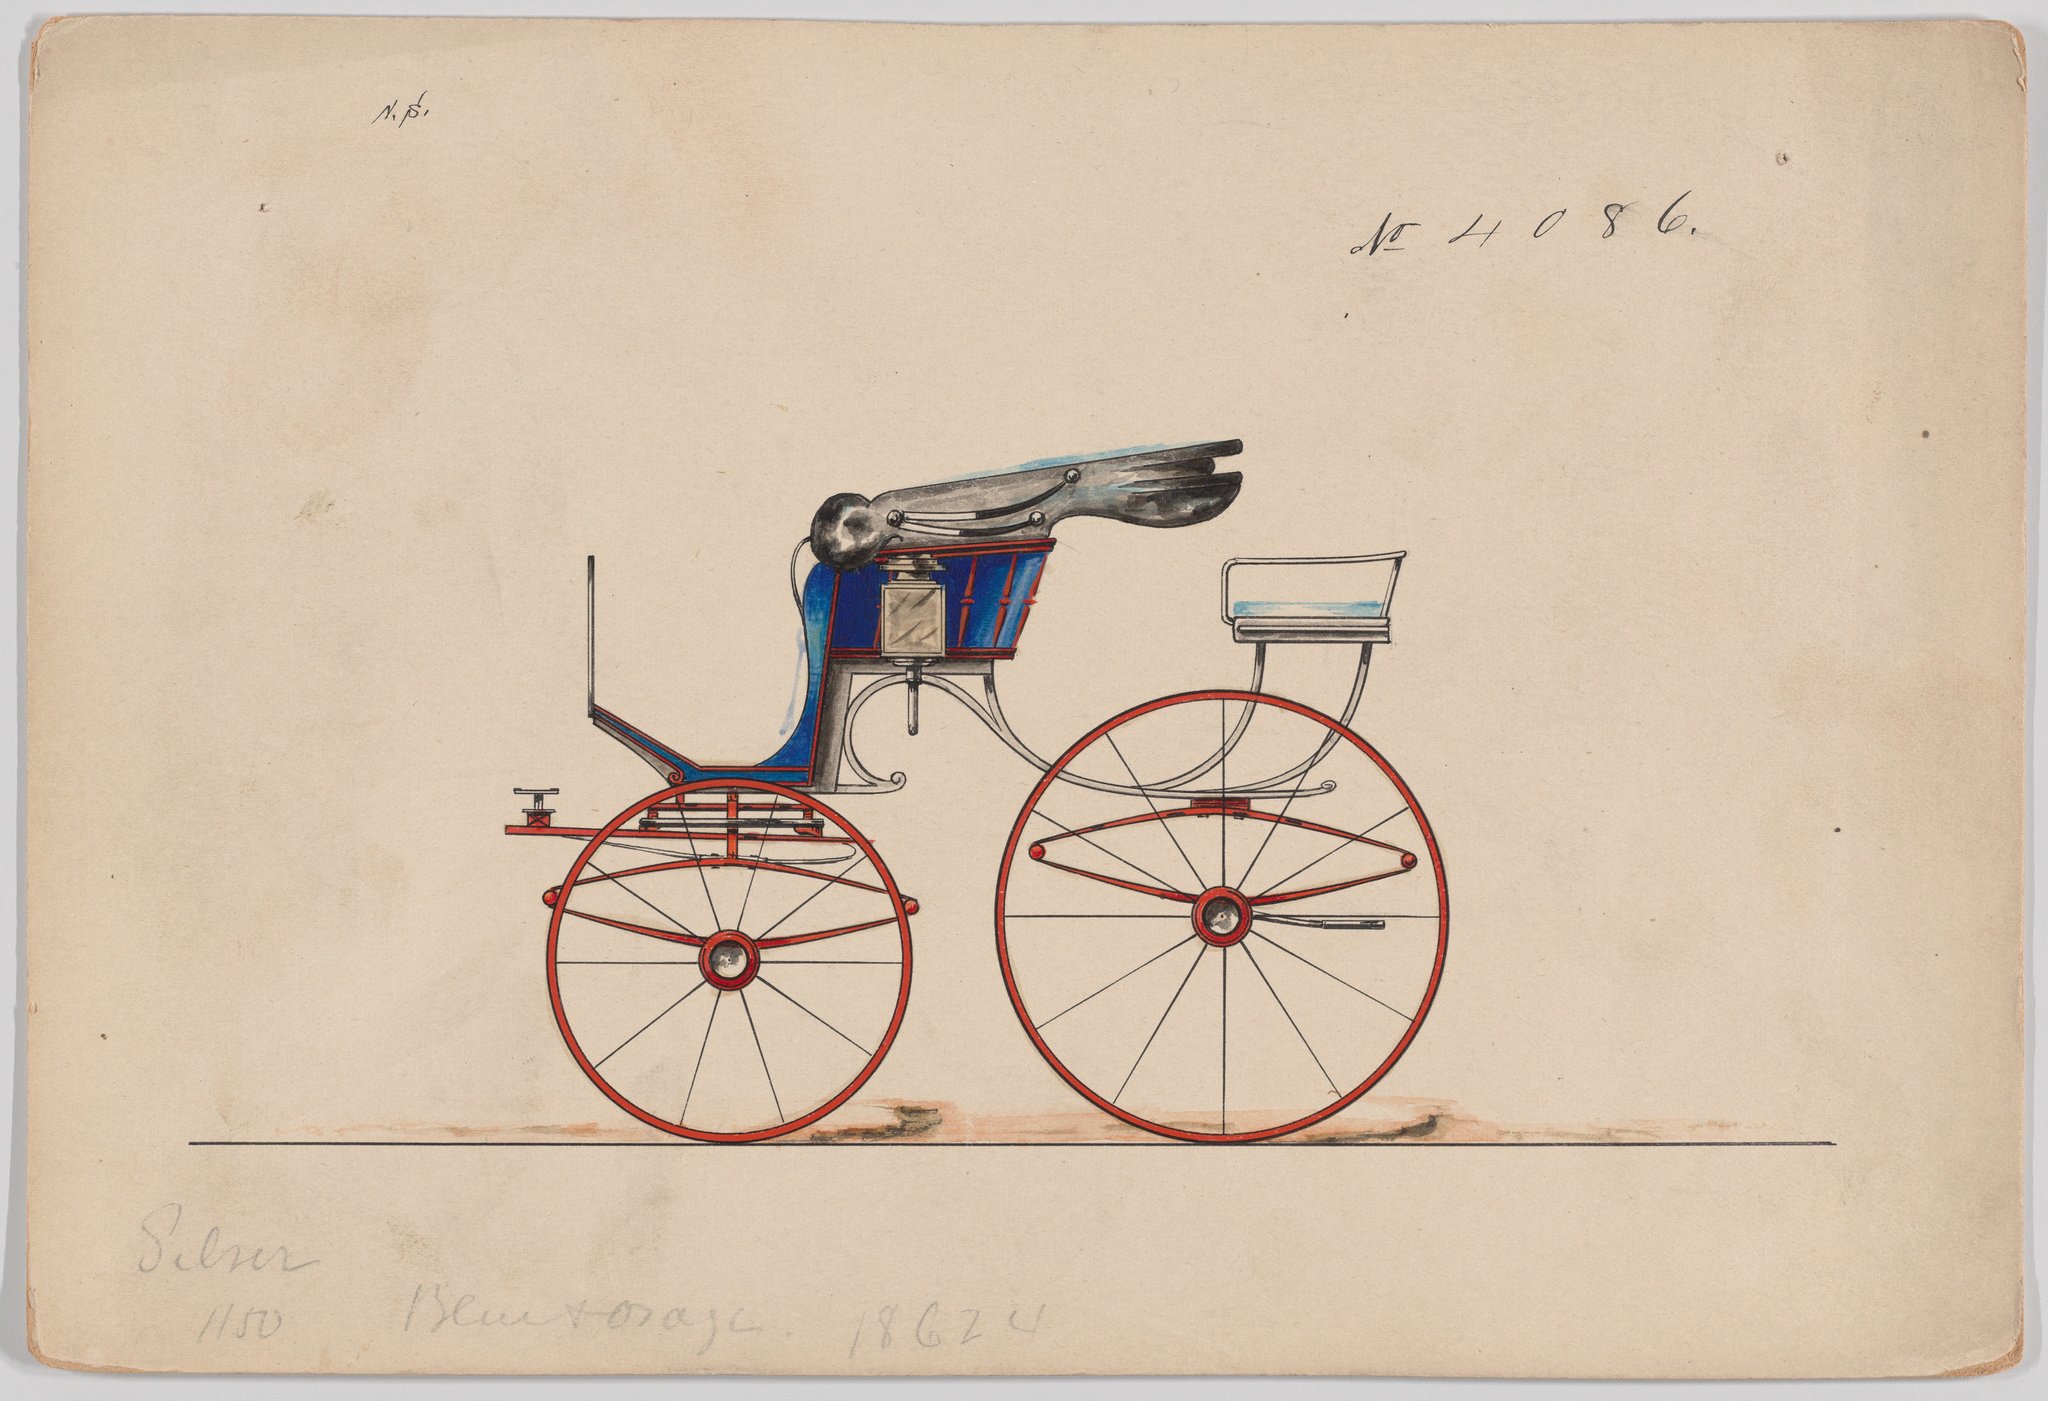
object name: drawing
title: Design for Pony Phaeton, no. 4086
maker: brewster & co.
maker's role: manufacturer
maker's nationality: american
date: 1890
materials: gouache, graphite, gum arabic, ink, watercolor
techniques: pen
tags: carriages